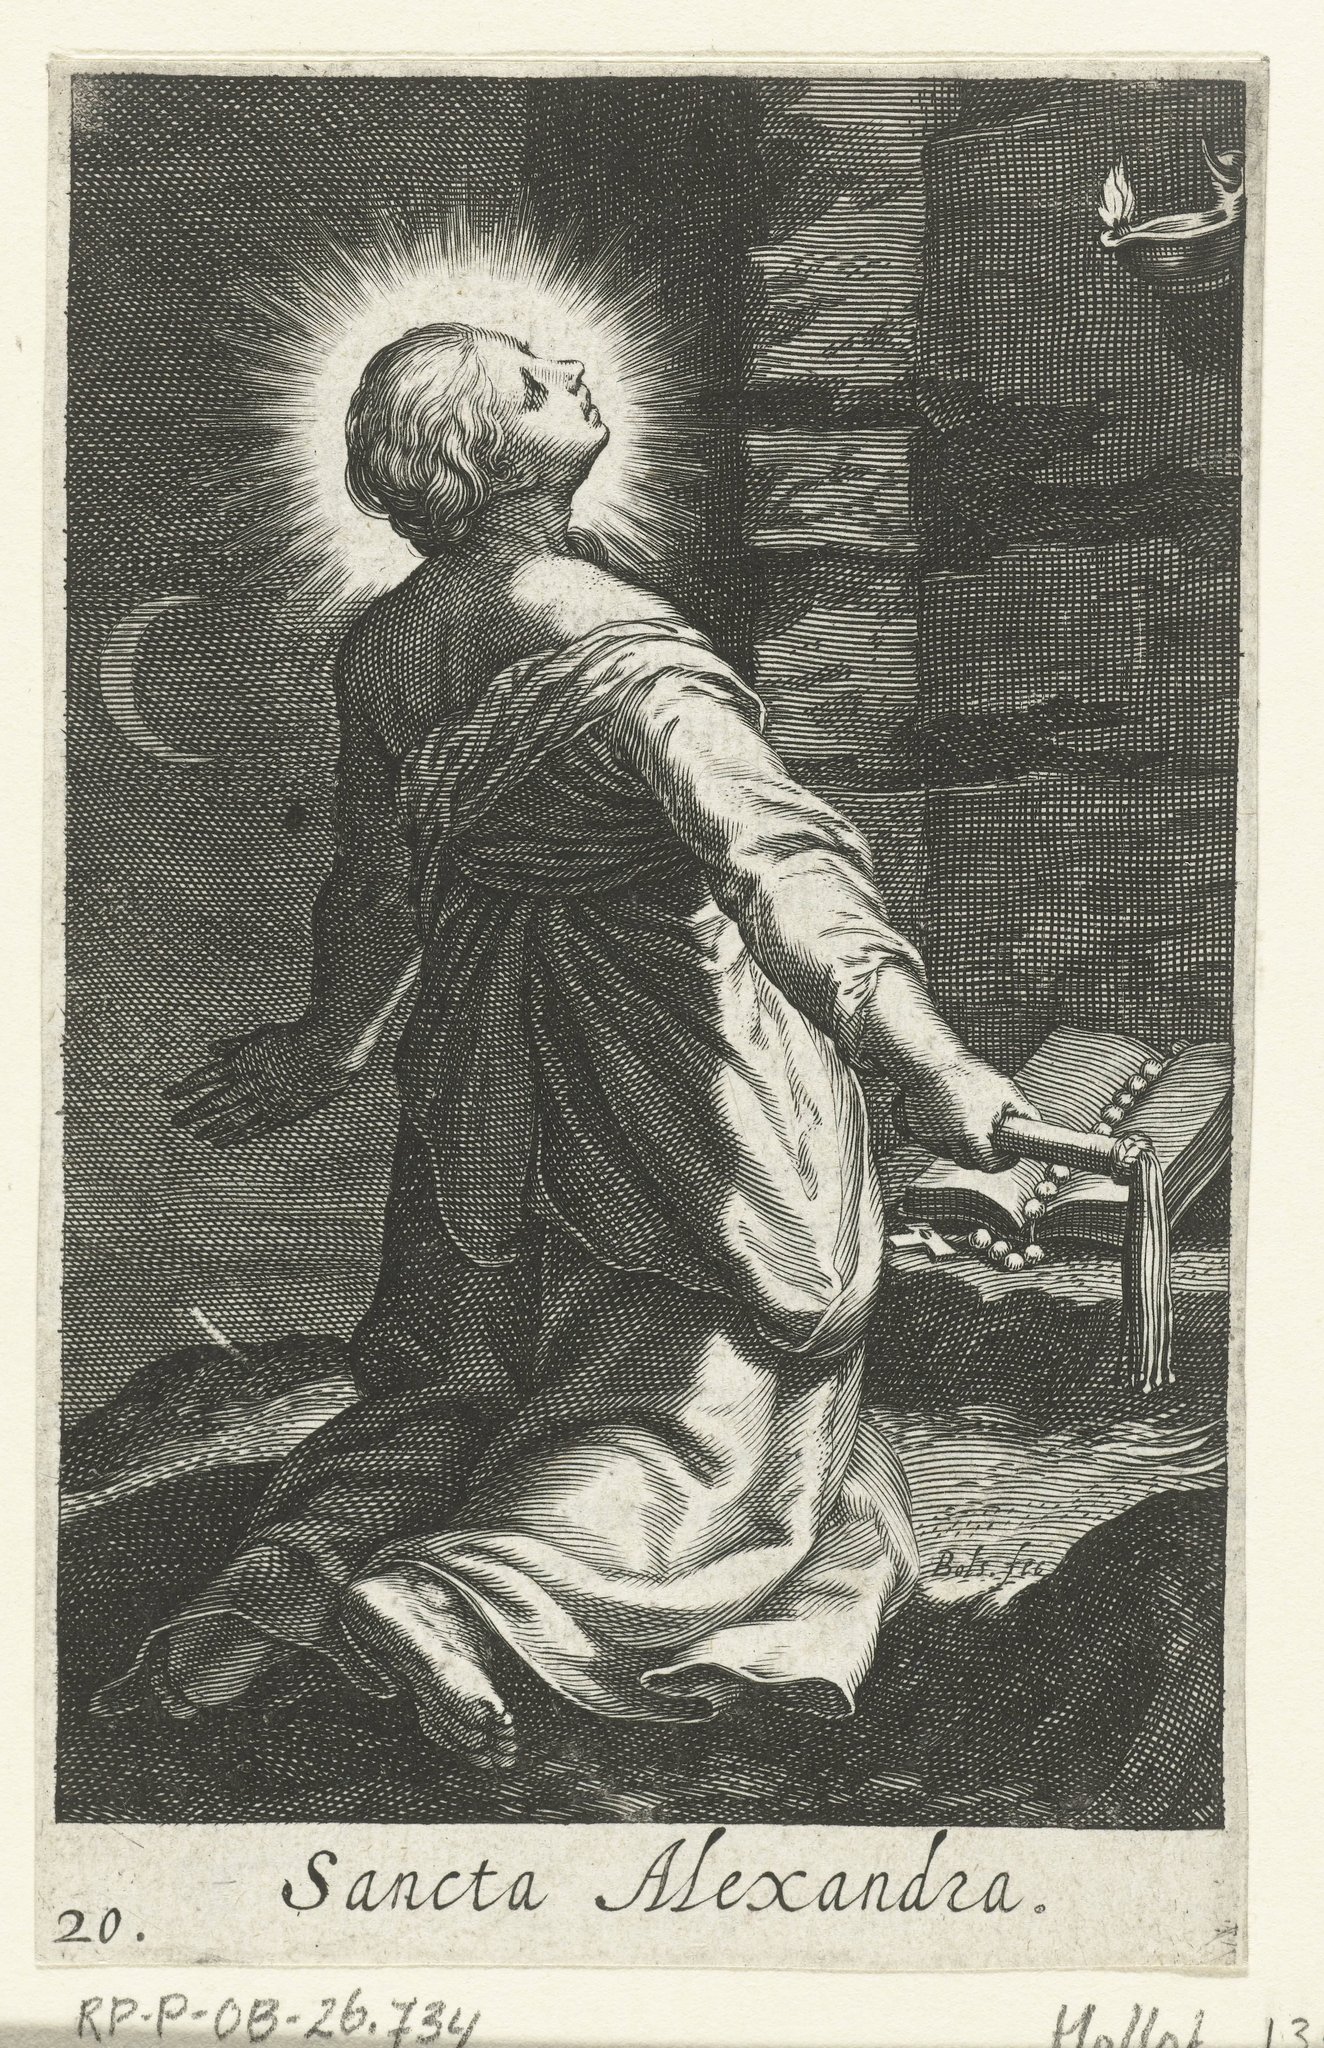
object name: print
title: Sancta Alexandra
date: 1590-1612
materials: paper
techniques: engraving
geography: antwerp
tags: anchorite, hermit, female saints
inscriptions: collector's mark: Lugt 2228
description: Prent uit: Sacra Eremus Ascetriarum, Hendrik Aertssen, Antwerpen 1619. Prent uit de serie van vijfentwintig kluizenaressen in deze uitgave. In 1612 verscheen de ongebonden editie maar op basis van de gewijzigde opschriften en samenstelling van de serie kluizenaars wordt aangenomen dat de prenten van de uitgave 1619 ook in 1612 of iets daarvoor gedrukt werden. De serie kluizenaressen bleef vrijwel ongewijzigd in de ongebonden uitgave van 1612, dit compliceert de datering van de losse bladen in de collectie van het RMA, zie Roethlisberger 1993, p. 171-175. Door de aanwezigheid van Franse tekst op het verso kunnen we vaststellen dat dit blad afkomstig is uit de Antwerpse uitgave van 1619.